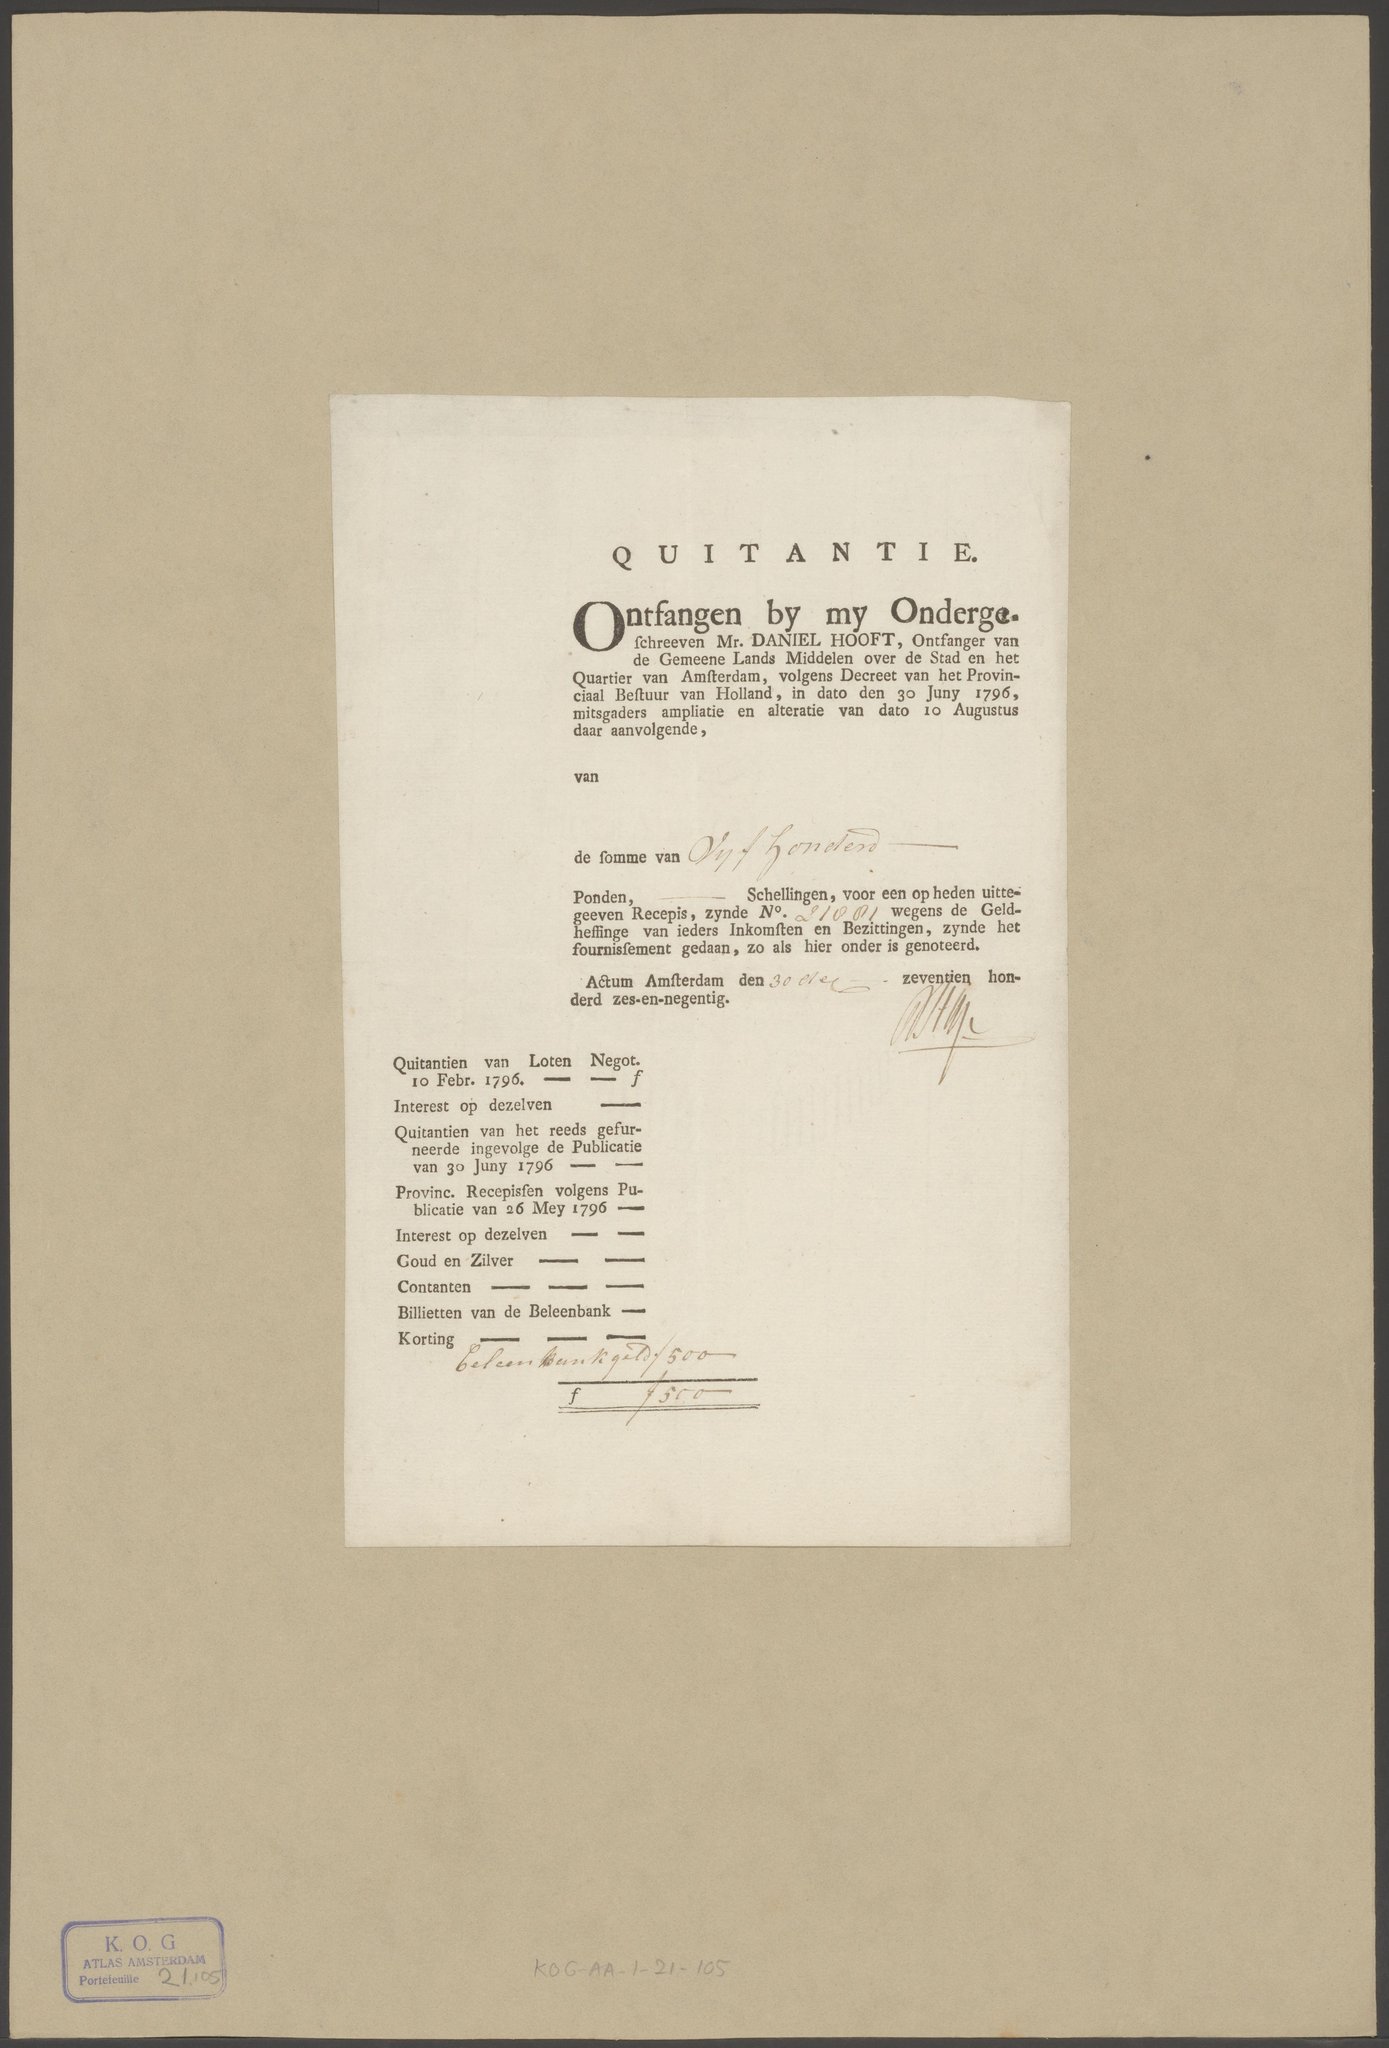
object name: document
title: Kwitantie op naam van een onbekende Amsterdammer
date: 1796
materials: ink, paper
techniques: letterpress printing, pen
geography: amsterdam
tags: inheritance, tax collection, tax payment, amsterdam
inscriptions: collector's mark: Lugt 1641b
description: Inzake betaling van de belasting over inkomsten en bezittingen, met schriftelijke aantekening dat deze is voldaan op 30 december 1796. Onderwerpsrubriek binnen de Atlas Amsterdam: Belastingen.